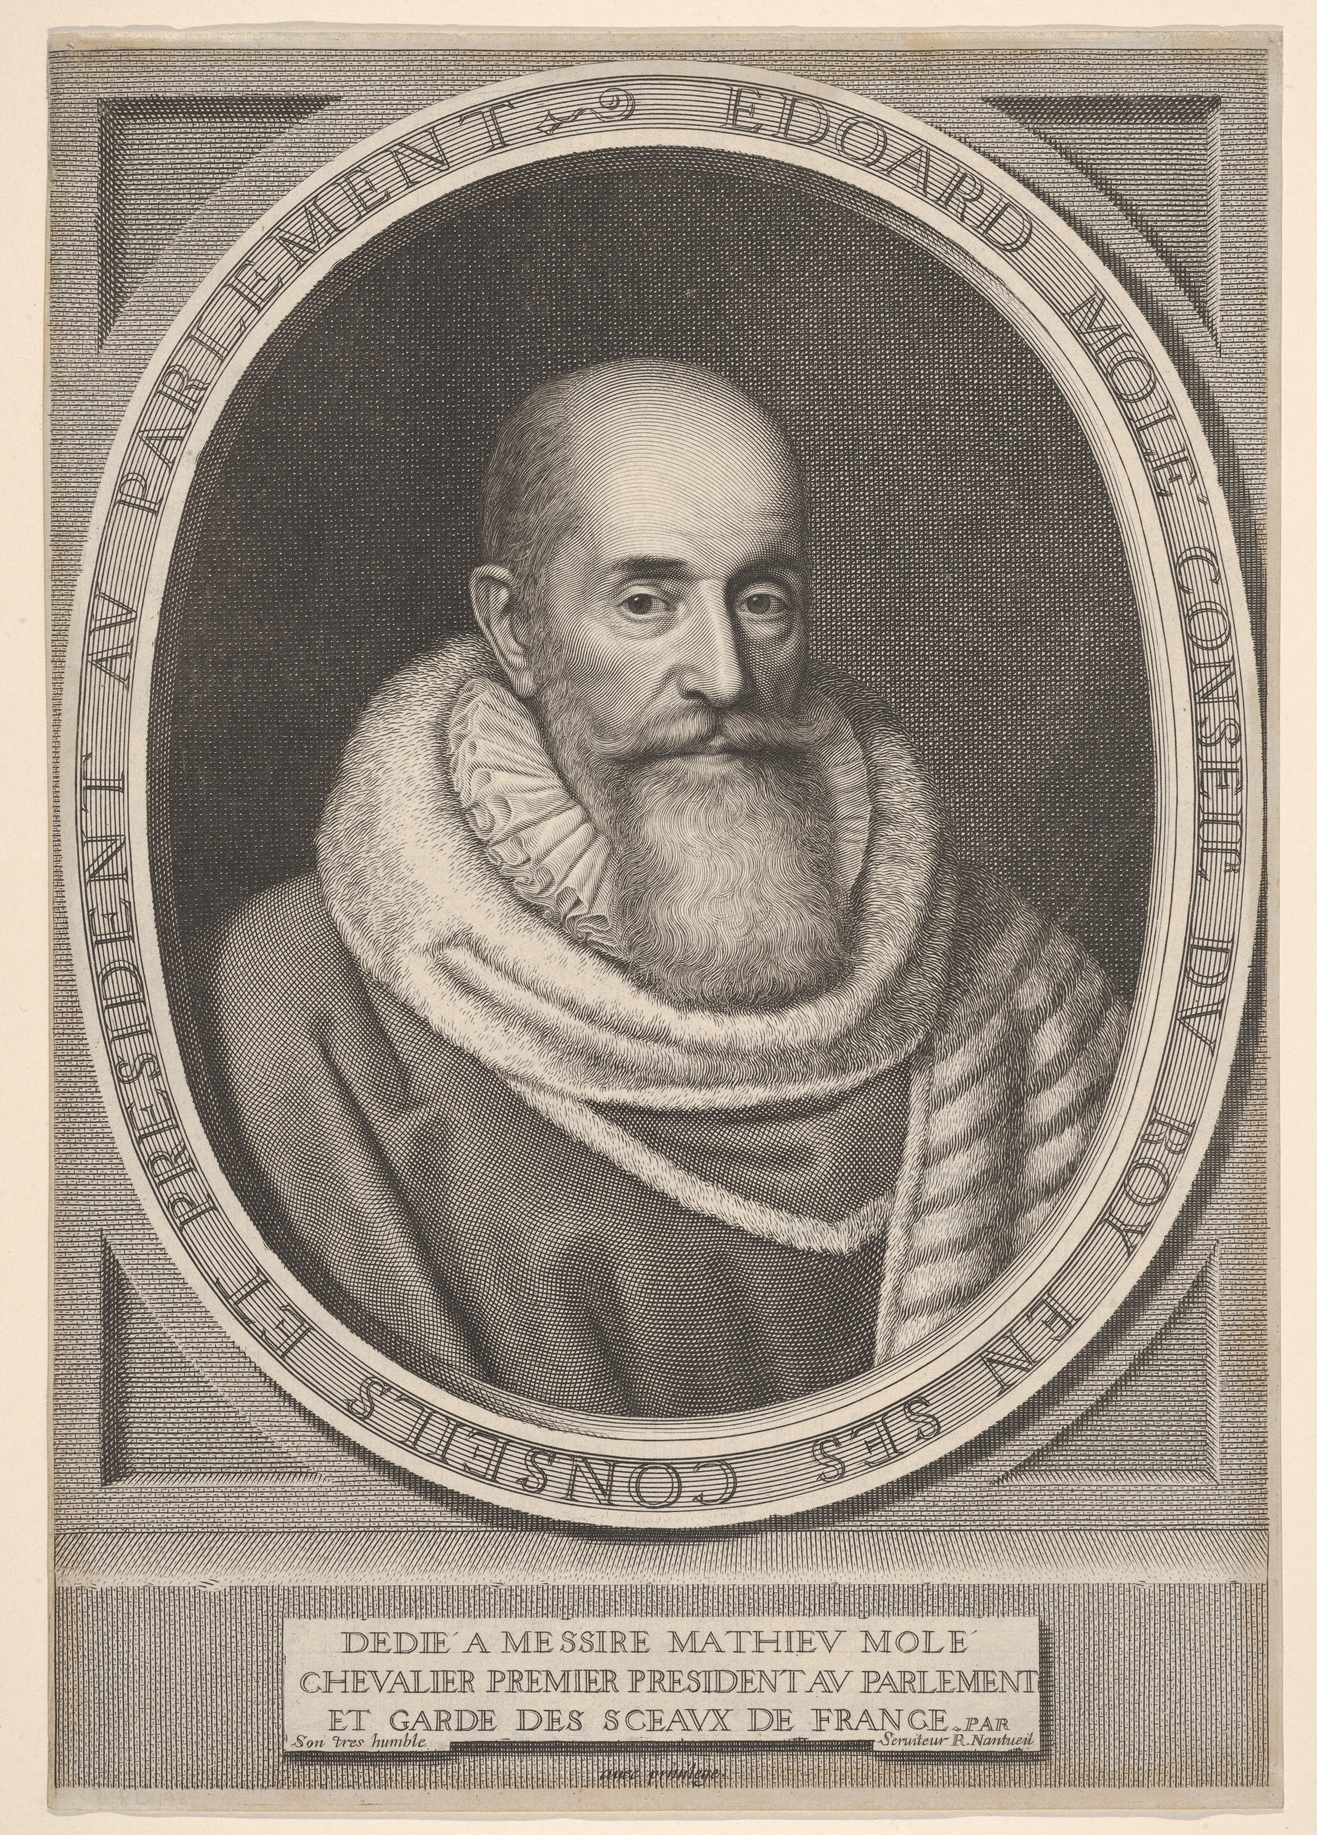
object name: print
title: Edouard Molé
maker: robert nanteuil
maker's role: artist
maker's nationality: french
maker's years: 1623-1678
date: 1653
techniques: engraving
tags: men,portraits